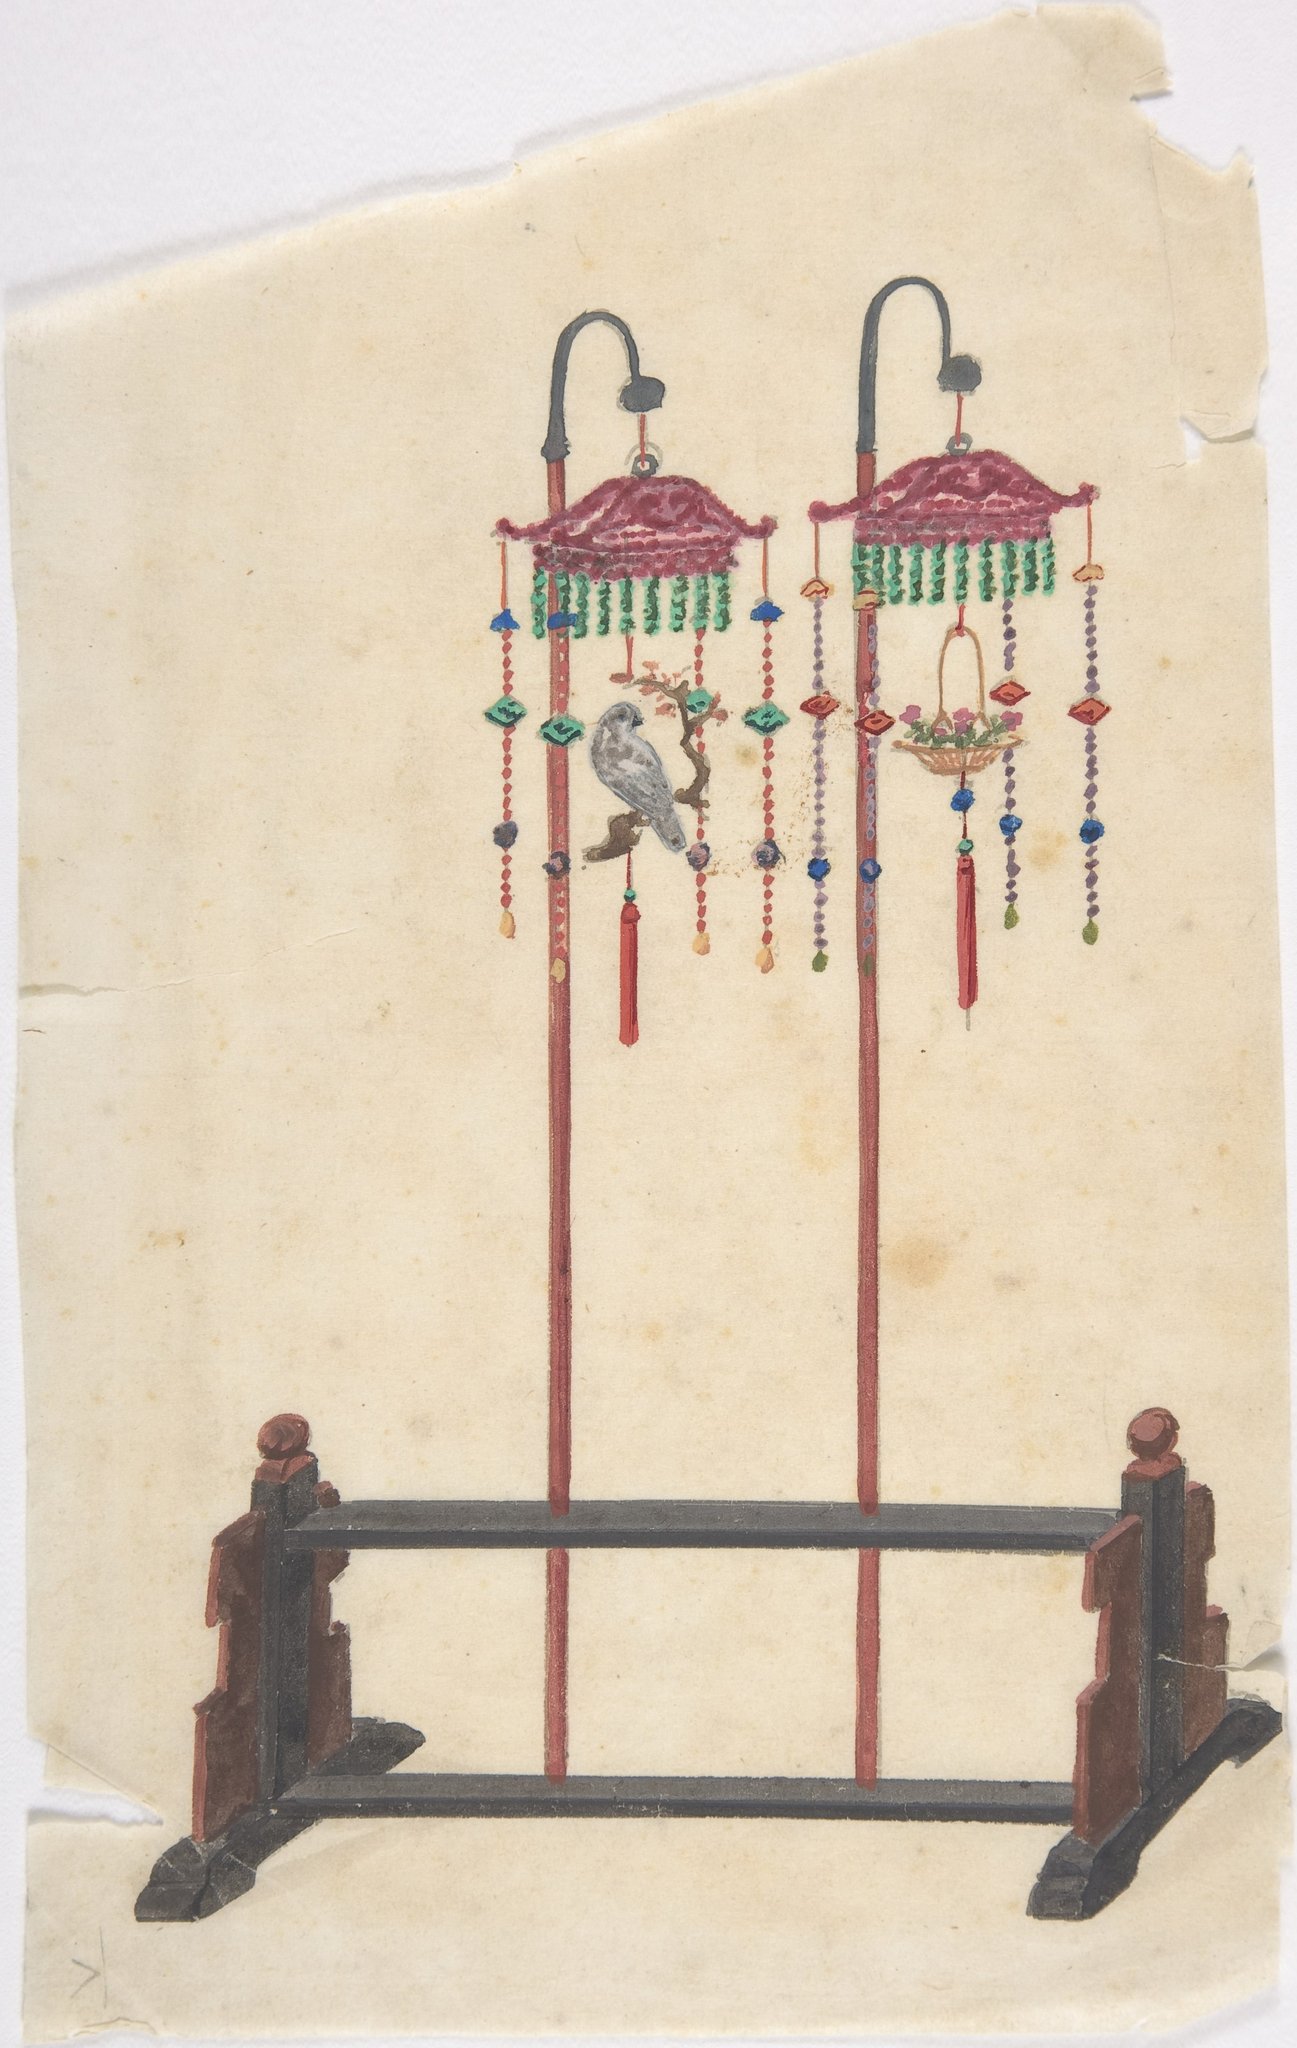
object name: drawing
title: Lamp Design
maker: anonymous, chinese, 19th century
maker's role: artist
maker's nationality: chinese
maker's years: 1800-1900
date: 1801-1900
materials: watercolor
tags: lamps